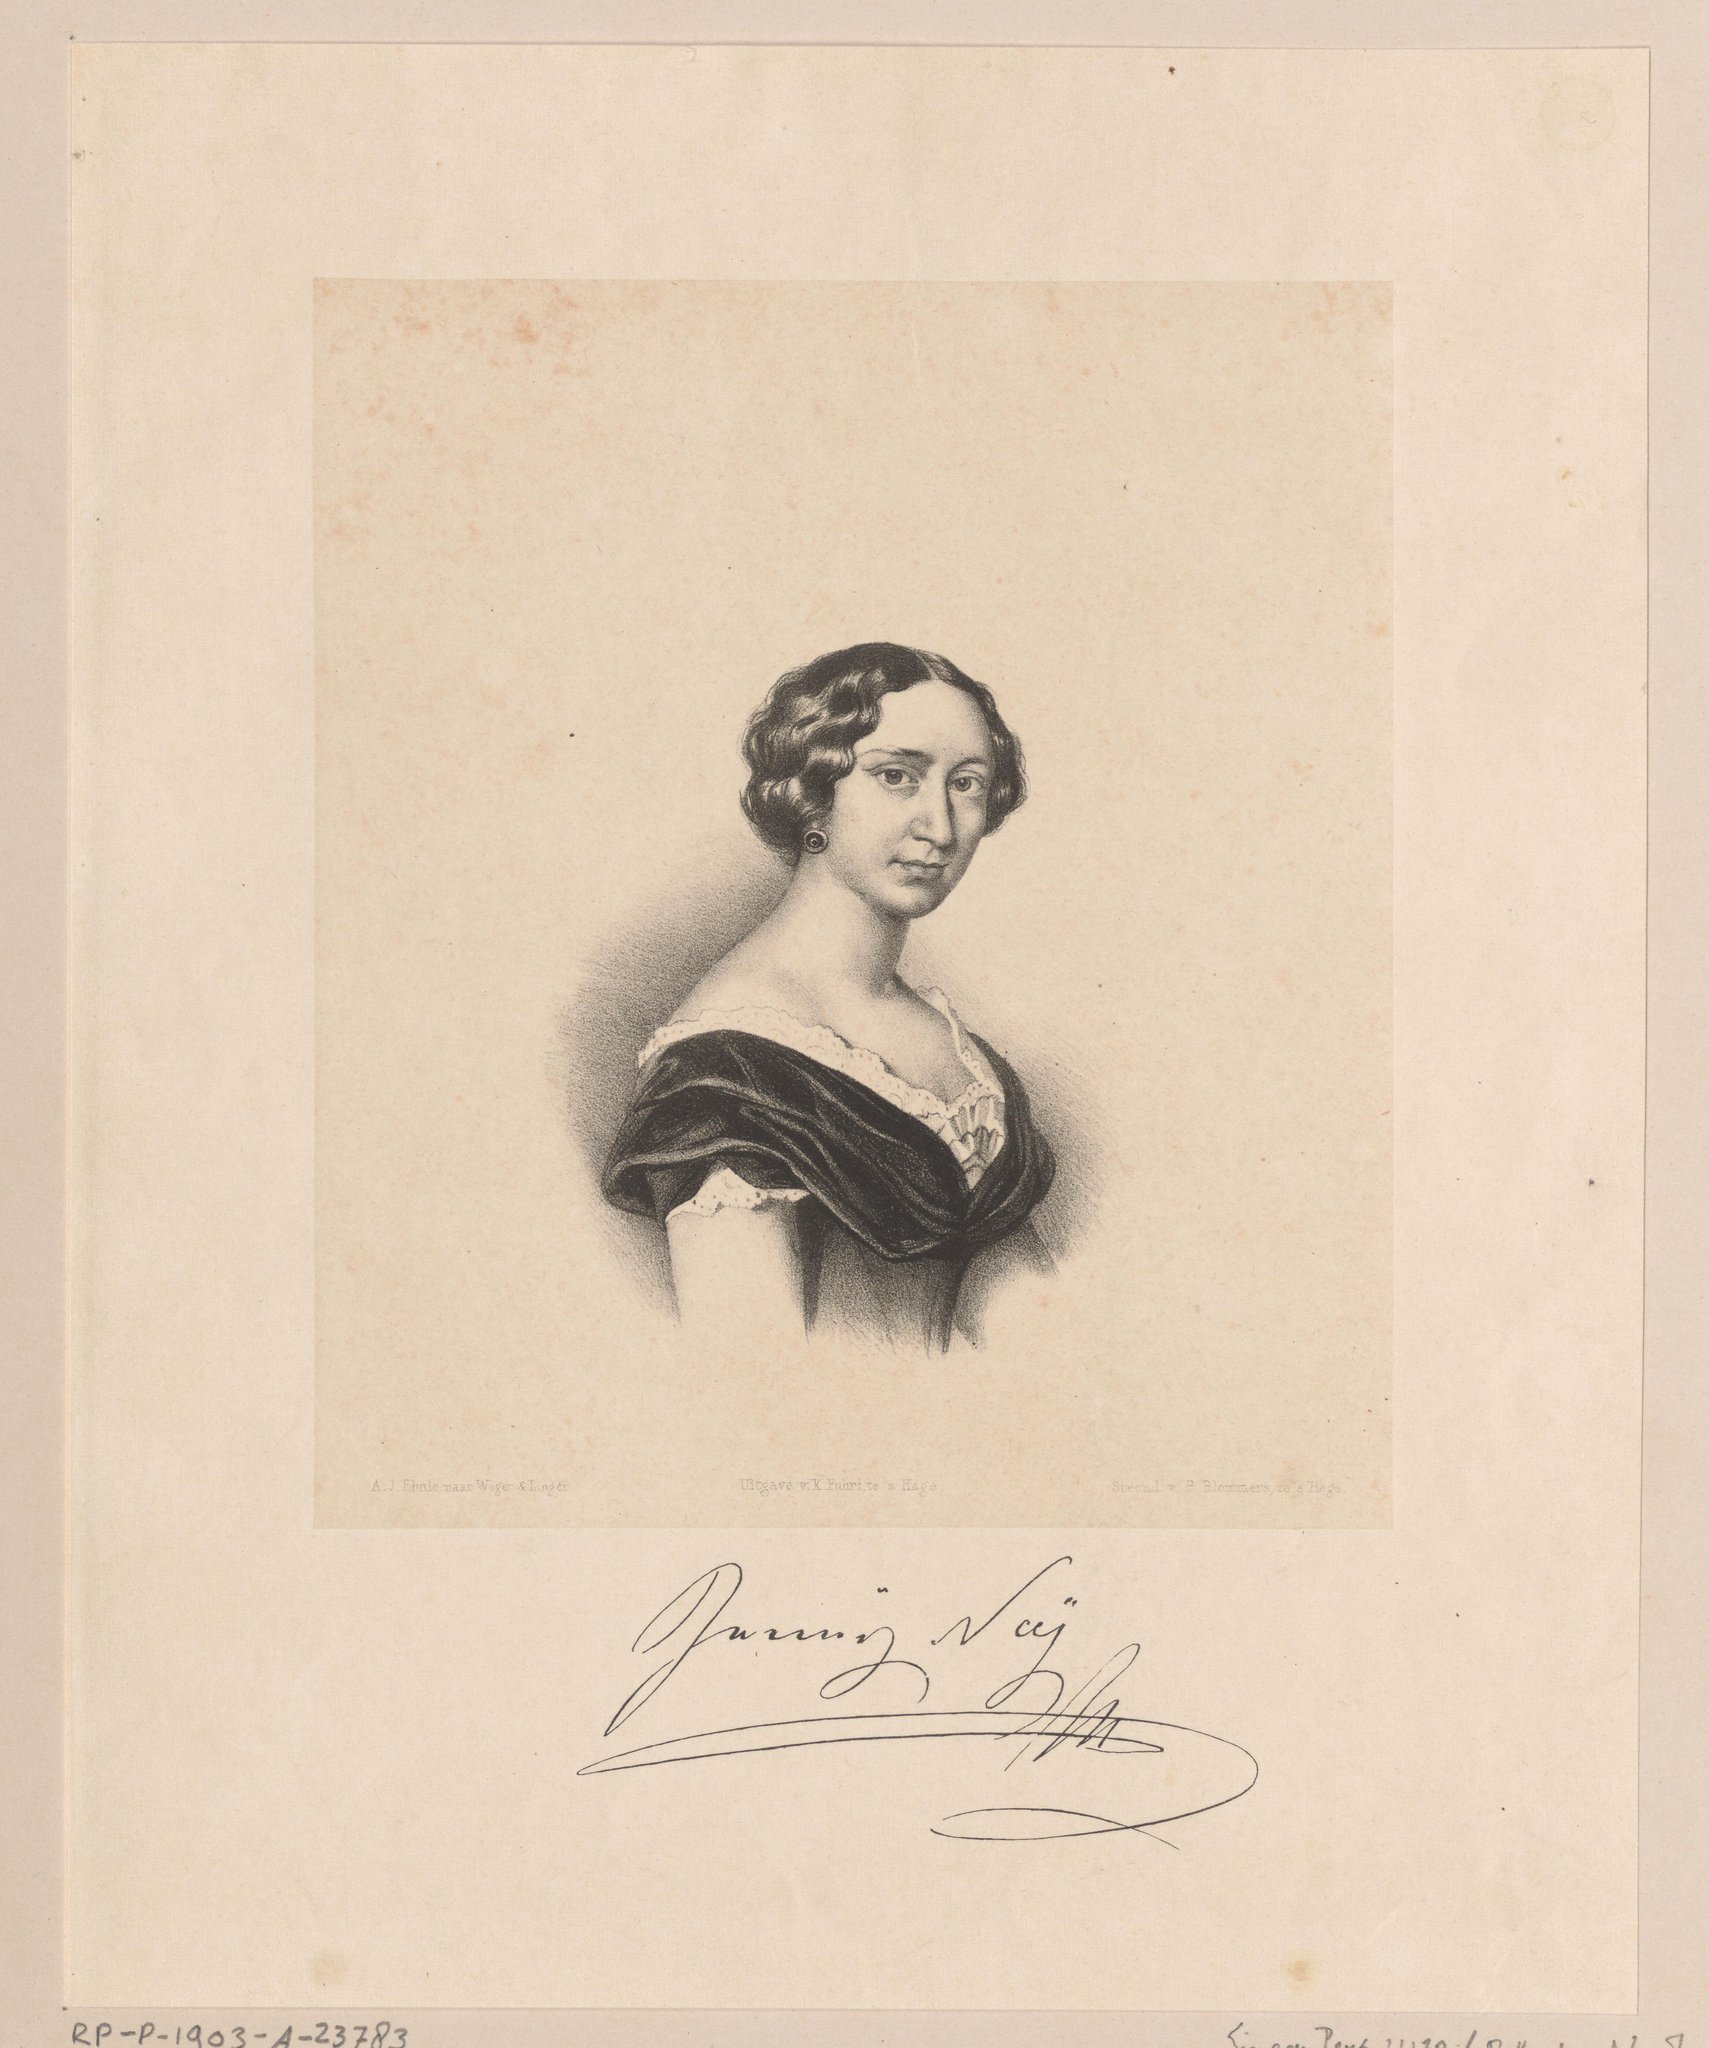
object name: print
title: De Maatschappij ter Bevordering van Toonkunst, haar Muziekfeest en de stad Rotterdam. Herinnering aan het jaar 1854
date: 1855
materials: paper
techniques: lithograph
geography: the hague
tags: historical persons - bb - woman, opera-singer (female)